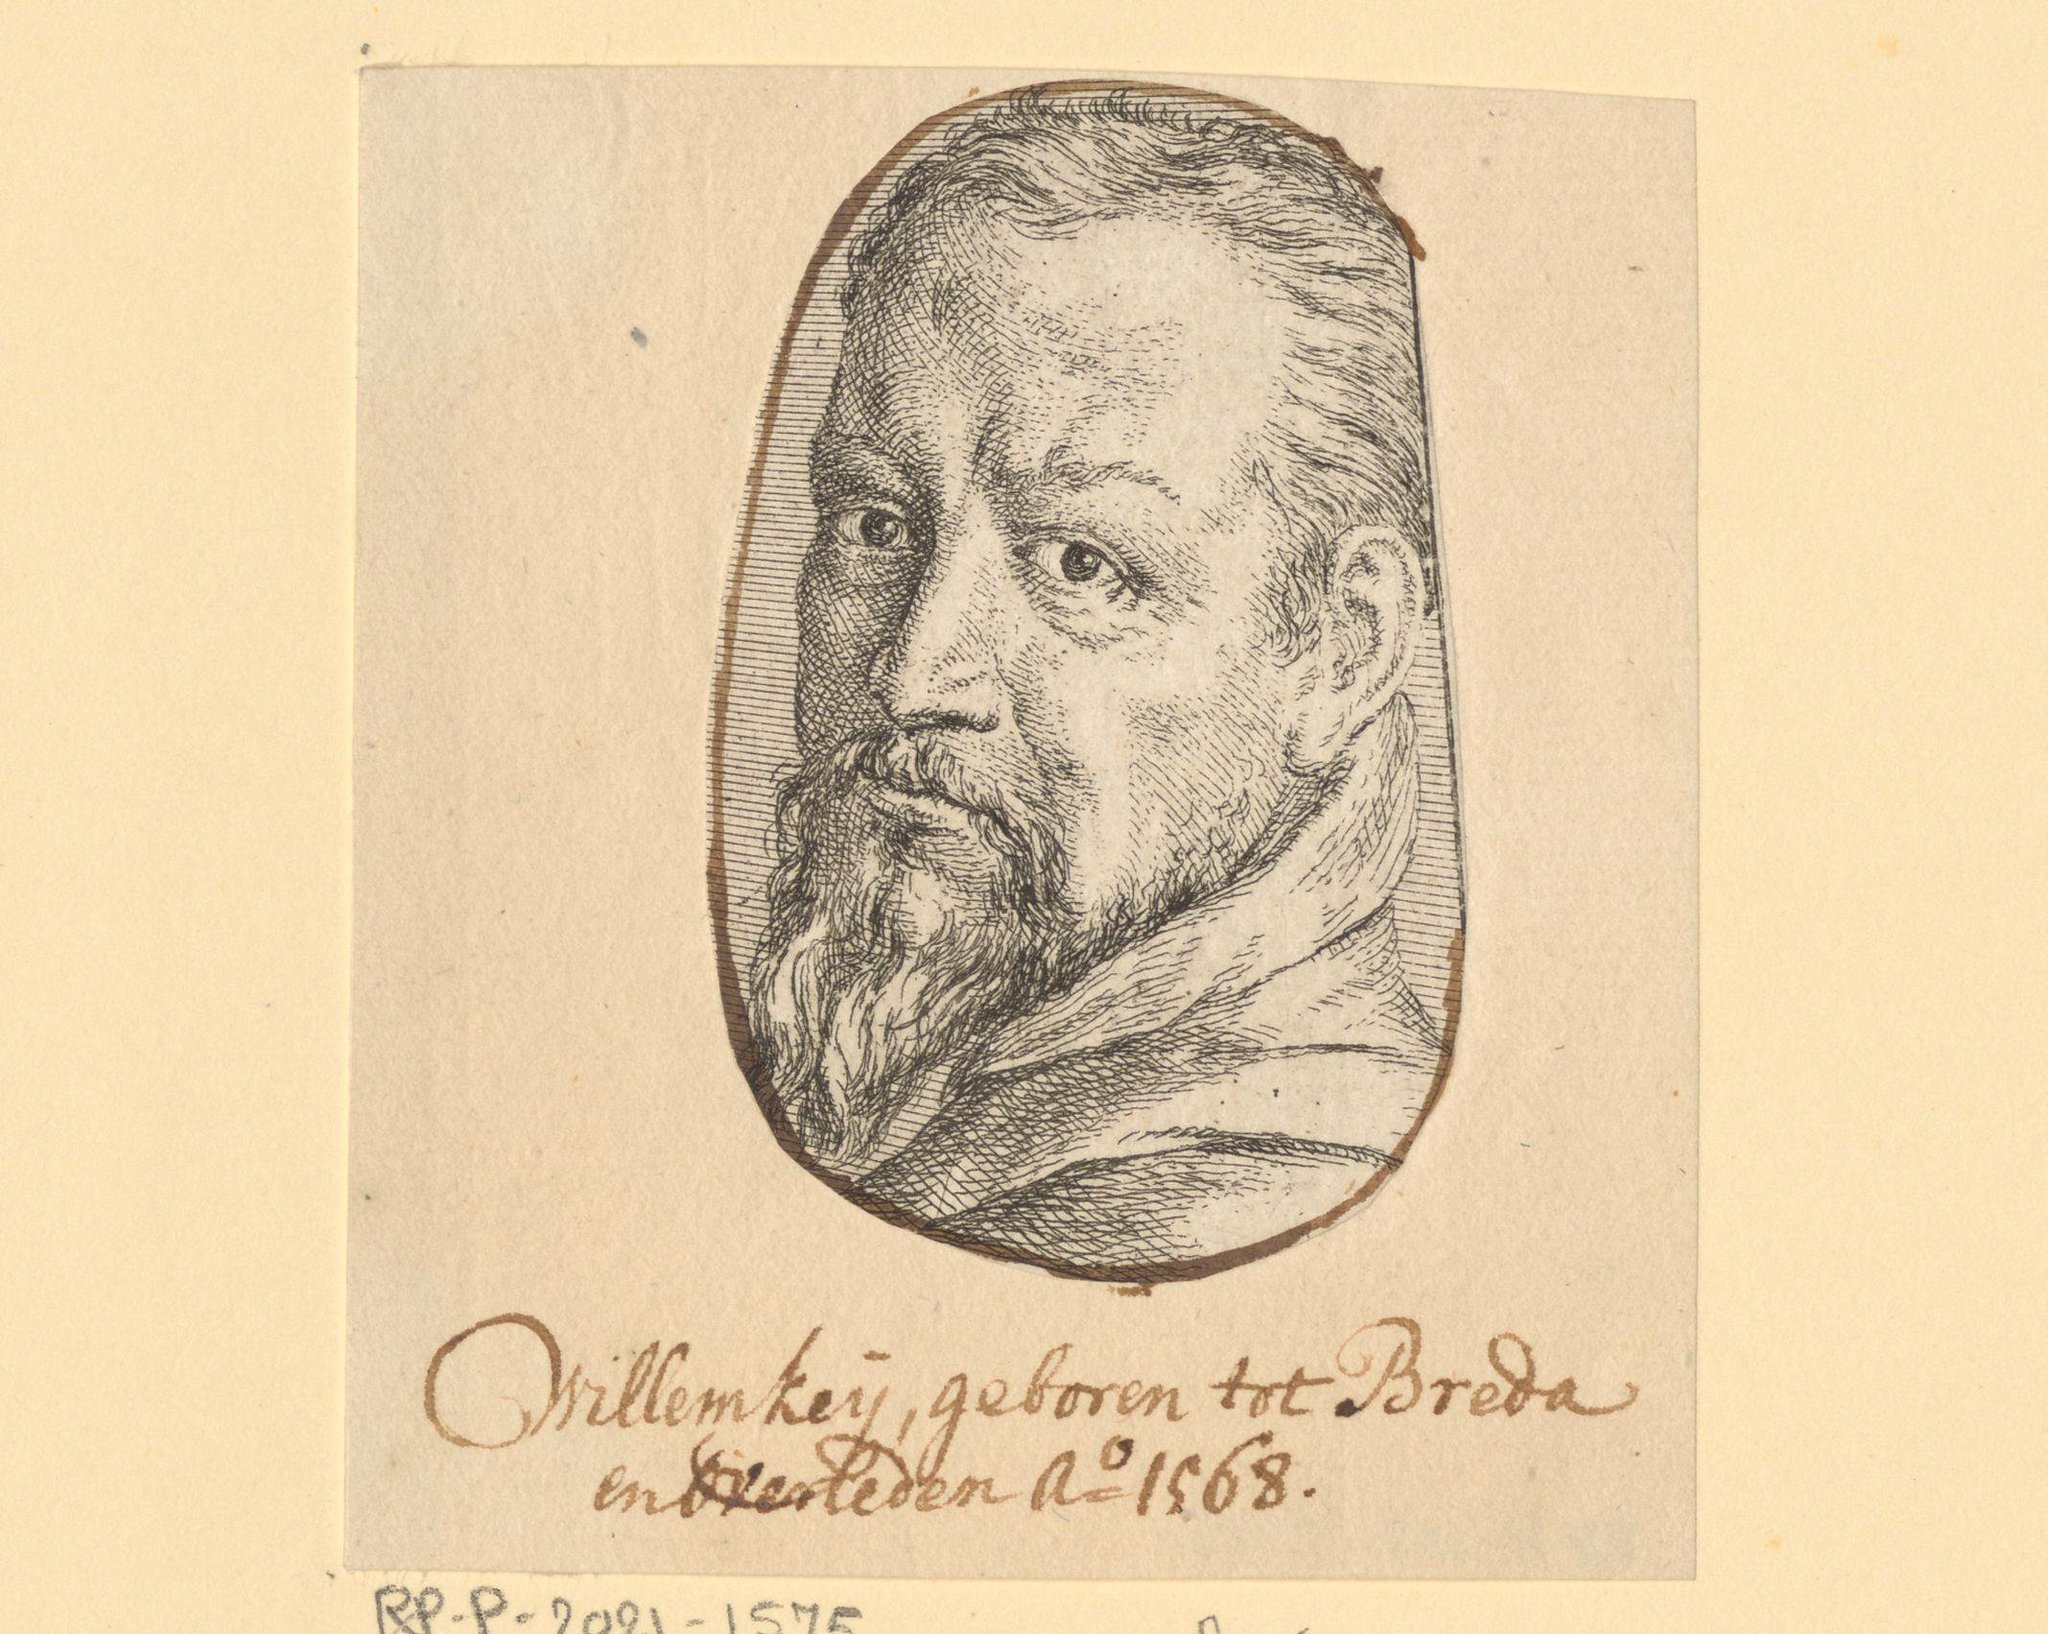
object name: print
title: Portret van Frans Floris I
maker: jan l admiral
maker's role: draughtsman, print maker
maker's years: 1699-1773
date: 1764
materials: paper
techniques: etching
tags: antwerp, print maker, draughtsman, frans floris (i), historical persons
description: Prent mogelijk uit: Mander, Karel van. Het leven der doorluchtige Nederlandsche en eenige Hoogduitsche schilders. Amsterdam: Steven van Esveldt, 1764.